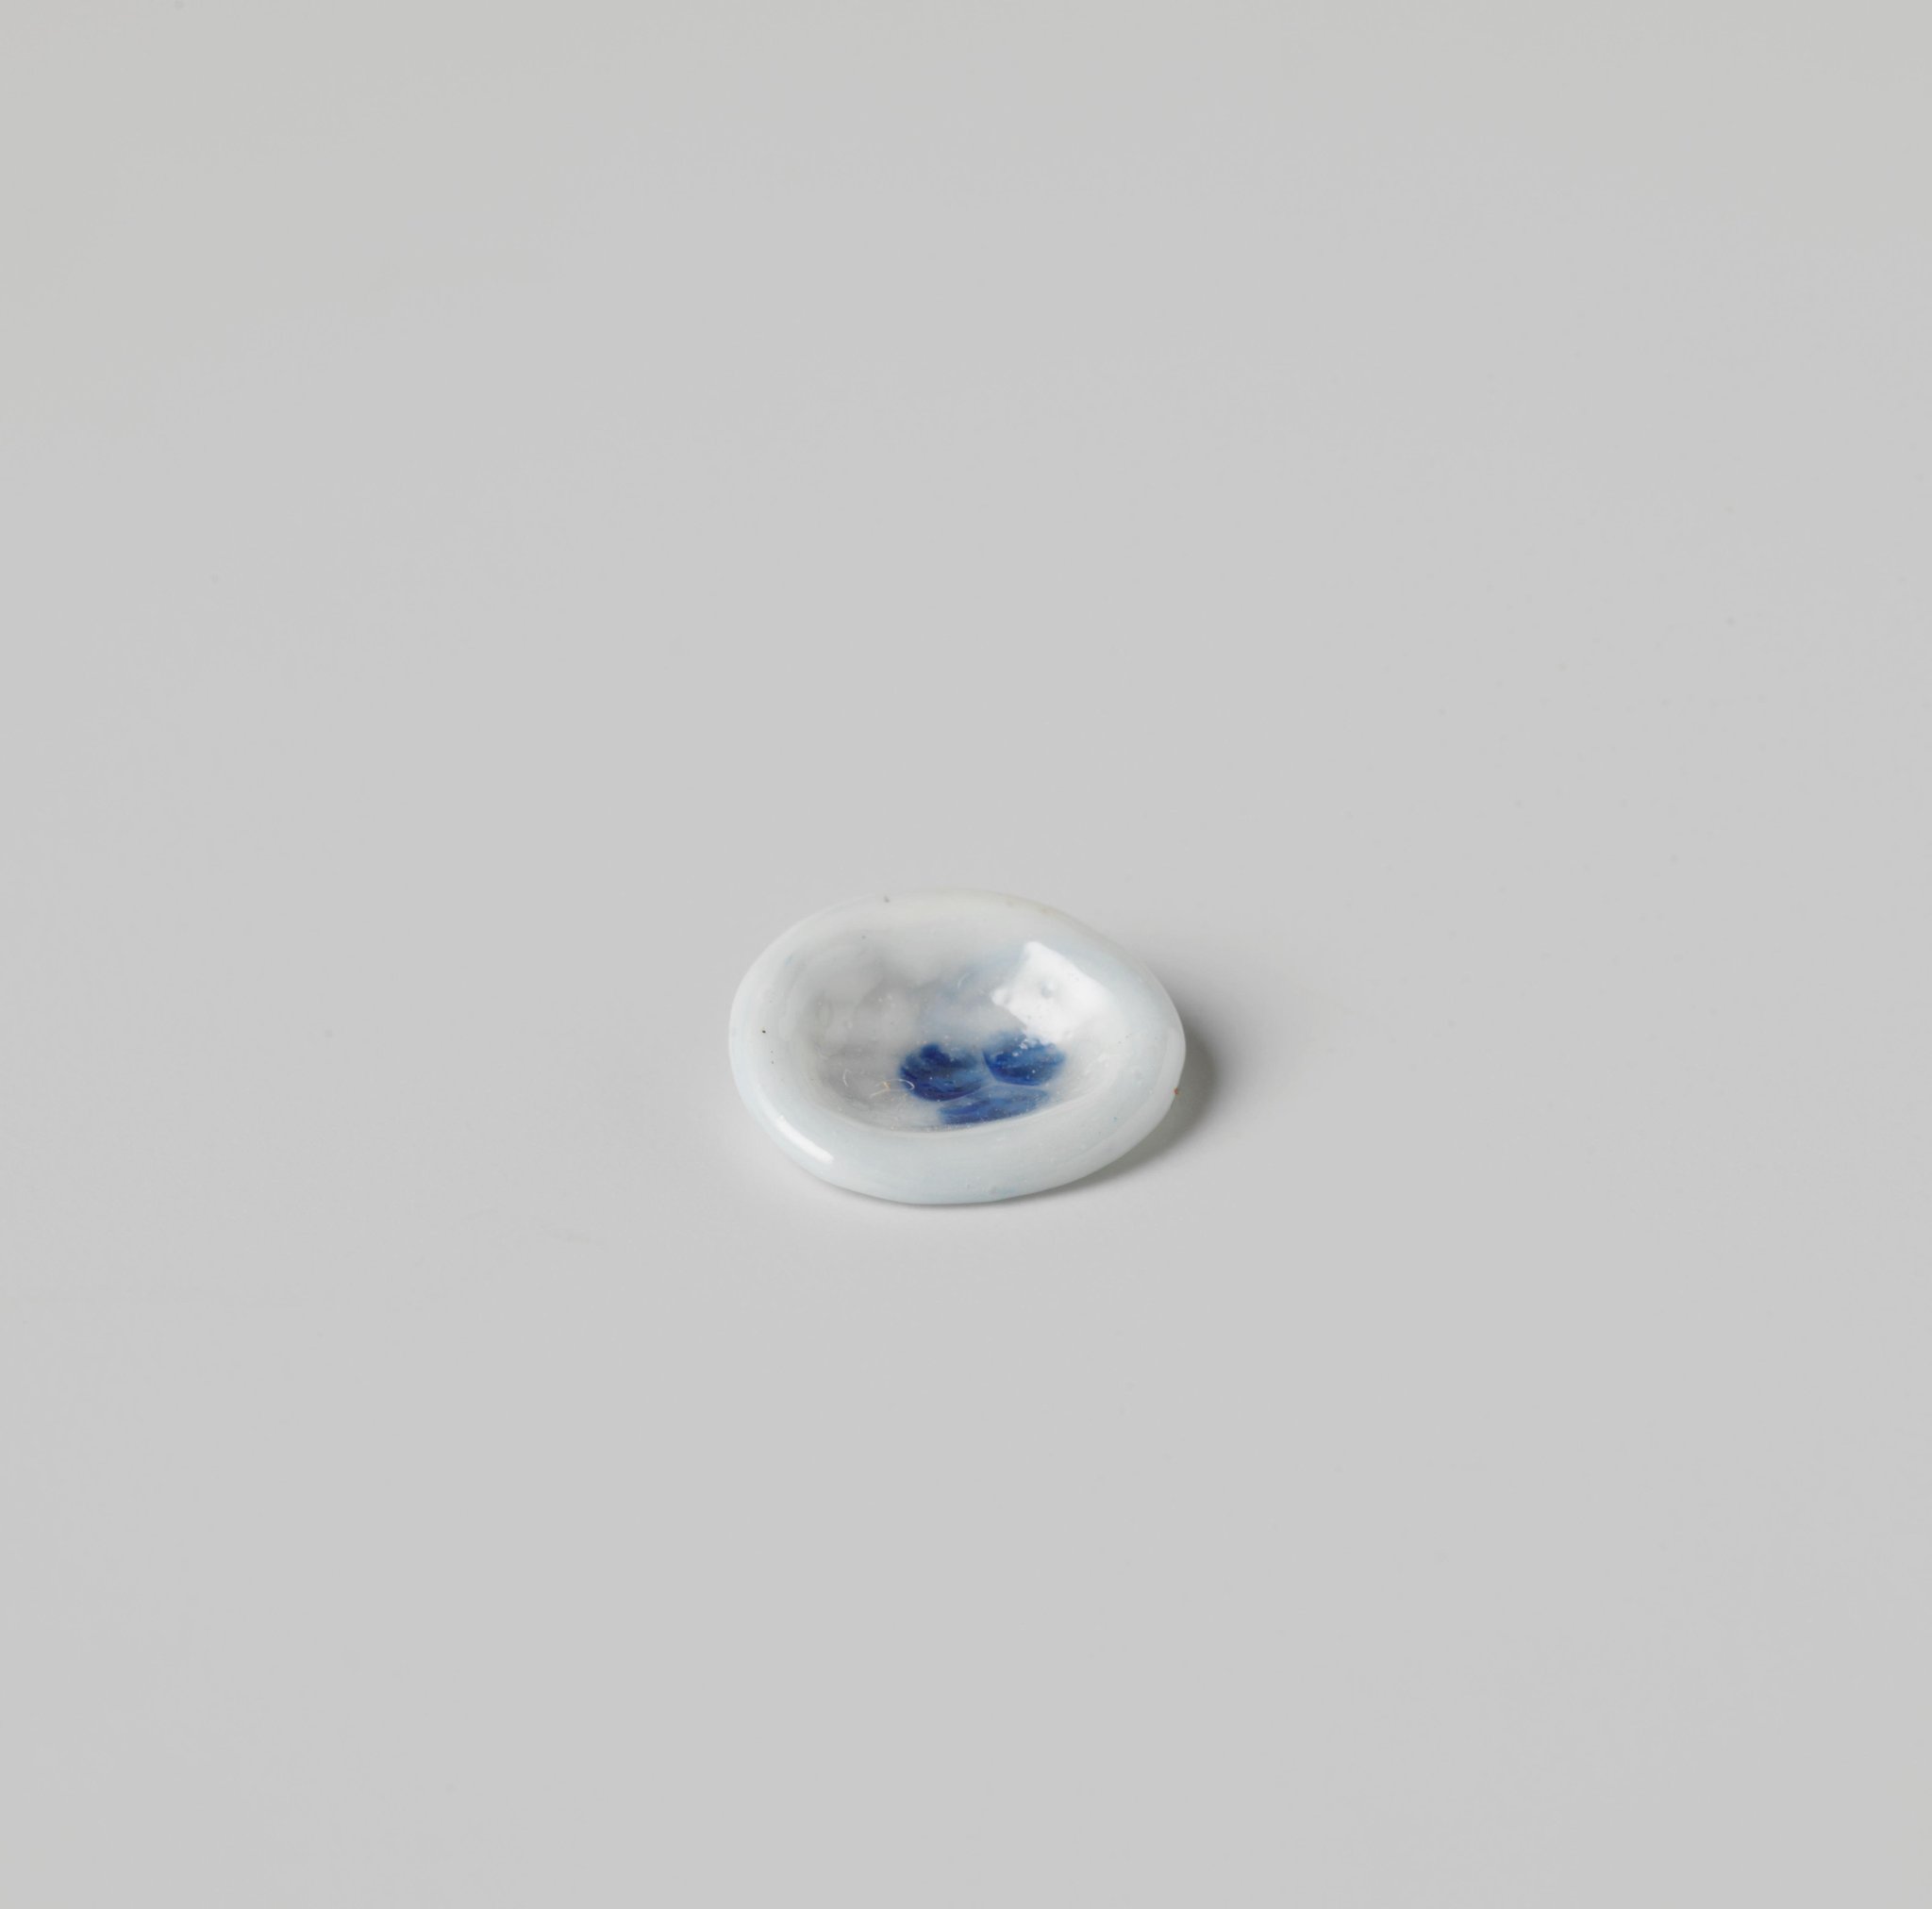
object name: miniature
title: Schotel, wit, beschilderd in blauw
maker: Anonymous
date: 1675-1699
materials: glass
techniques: enamel painting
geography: amsterdam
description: Schotel van melkglas met blauwe emailverf beschildering; dubbele laag en hol van binnen.